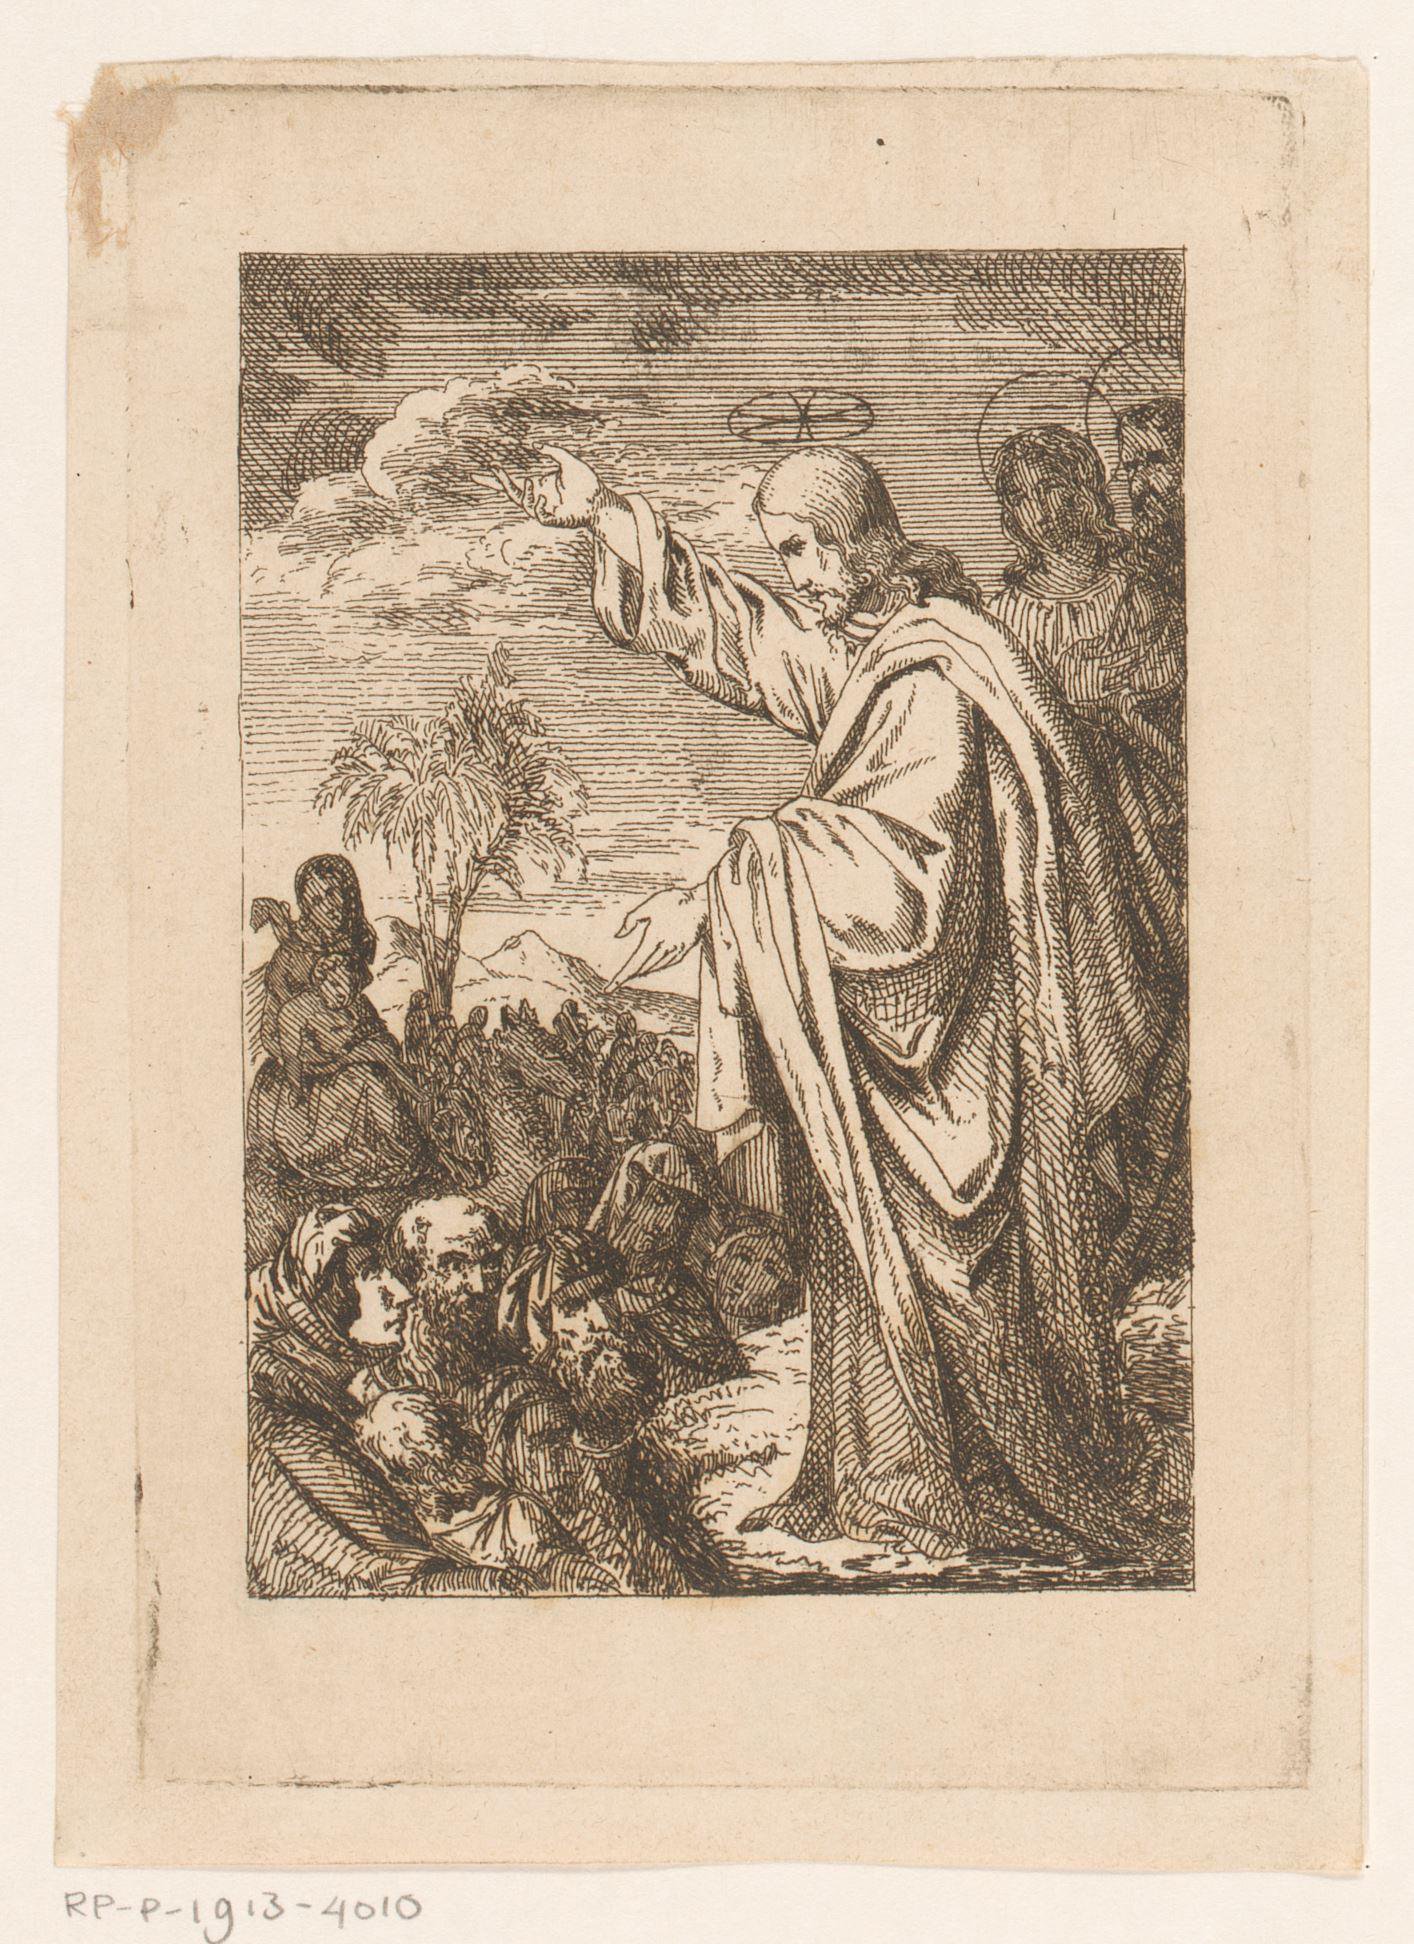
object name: print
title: Bergrede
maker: heinrich vianden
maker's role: painter, print maker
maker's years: 1814-1899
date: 1824-1899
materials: paper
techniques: etching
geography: germany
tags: christ's sermon on the mount (matthew 5-7)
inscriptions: collector's mark: Lugt 2228, collector's mark: Lugt 1485